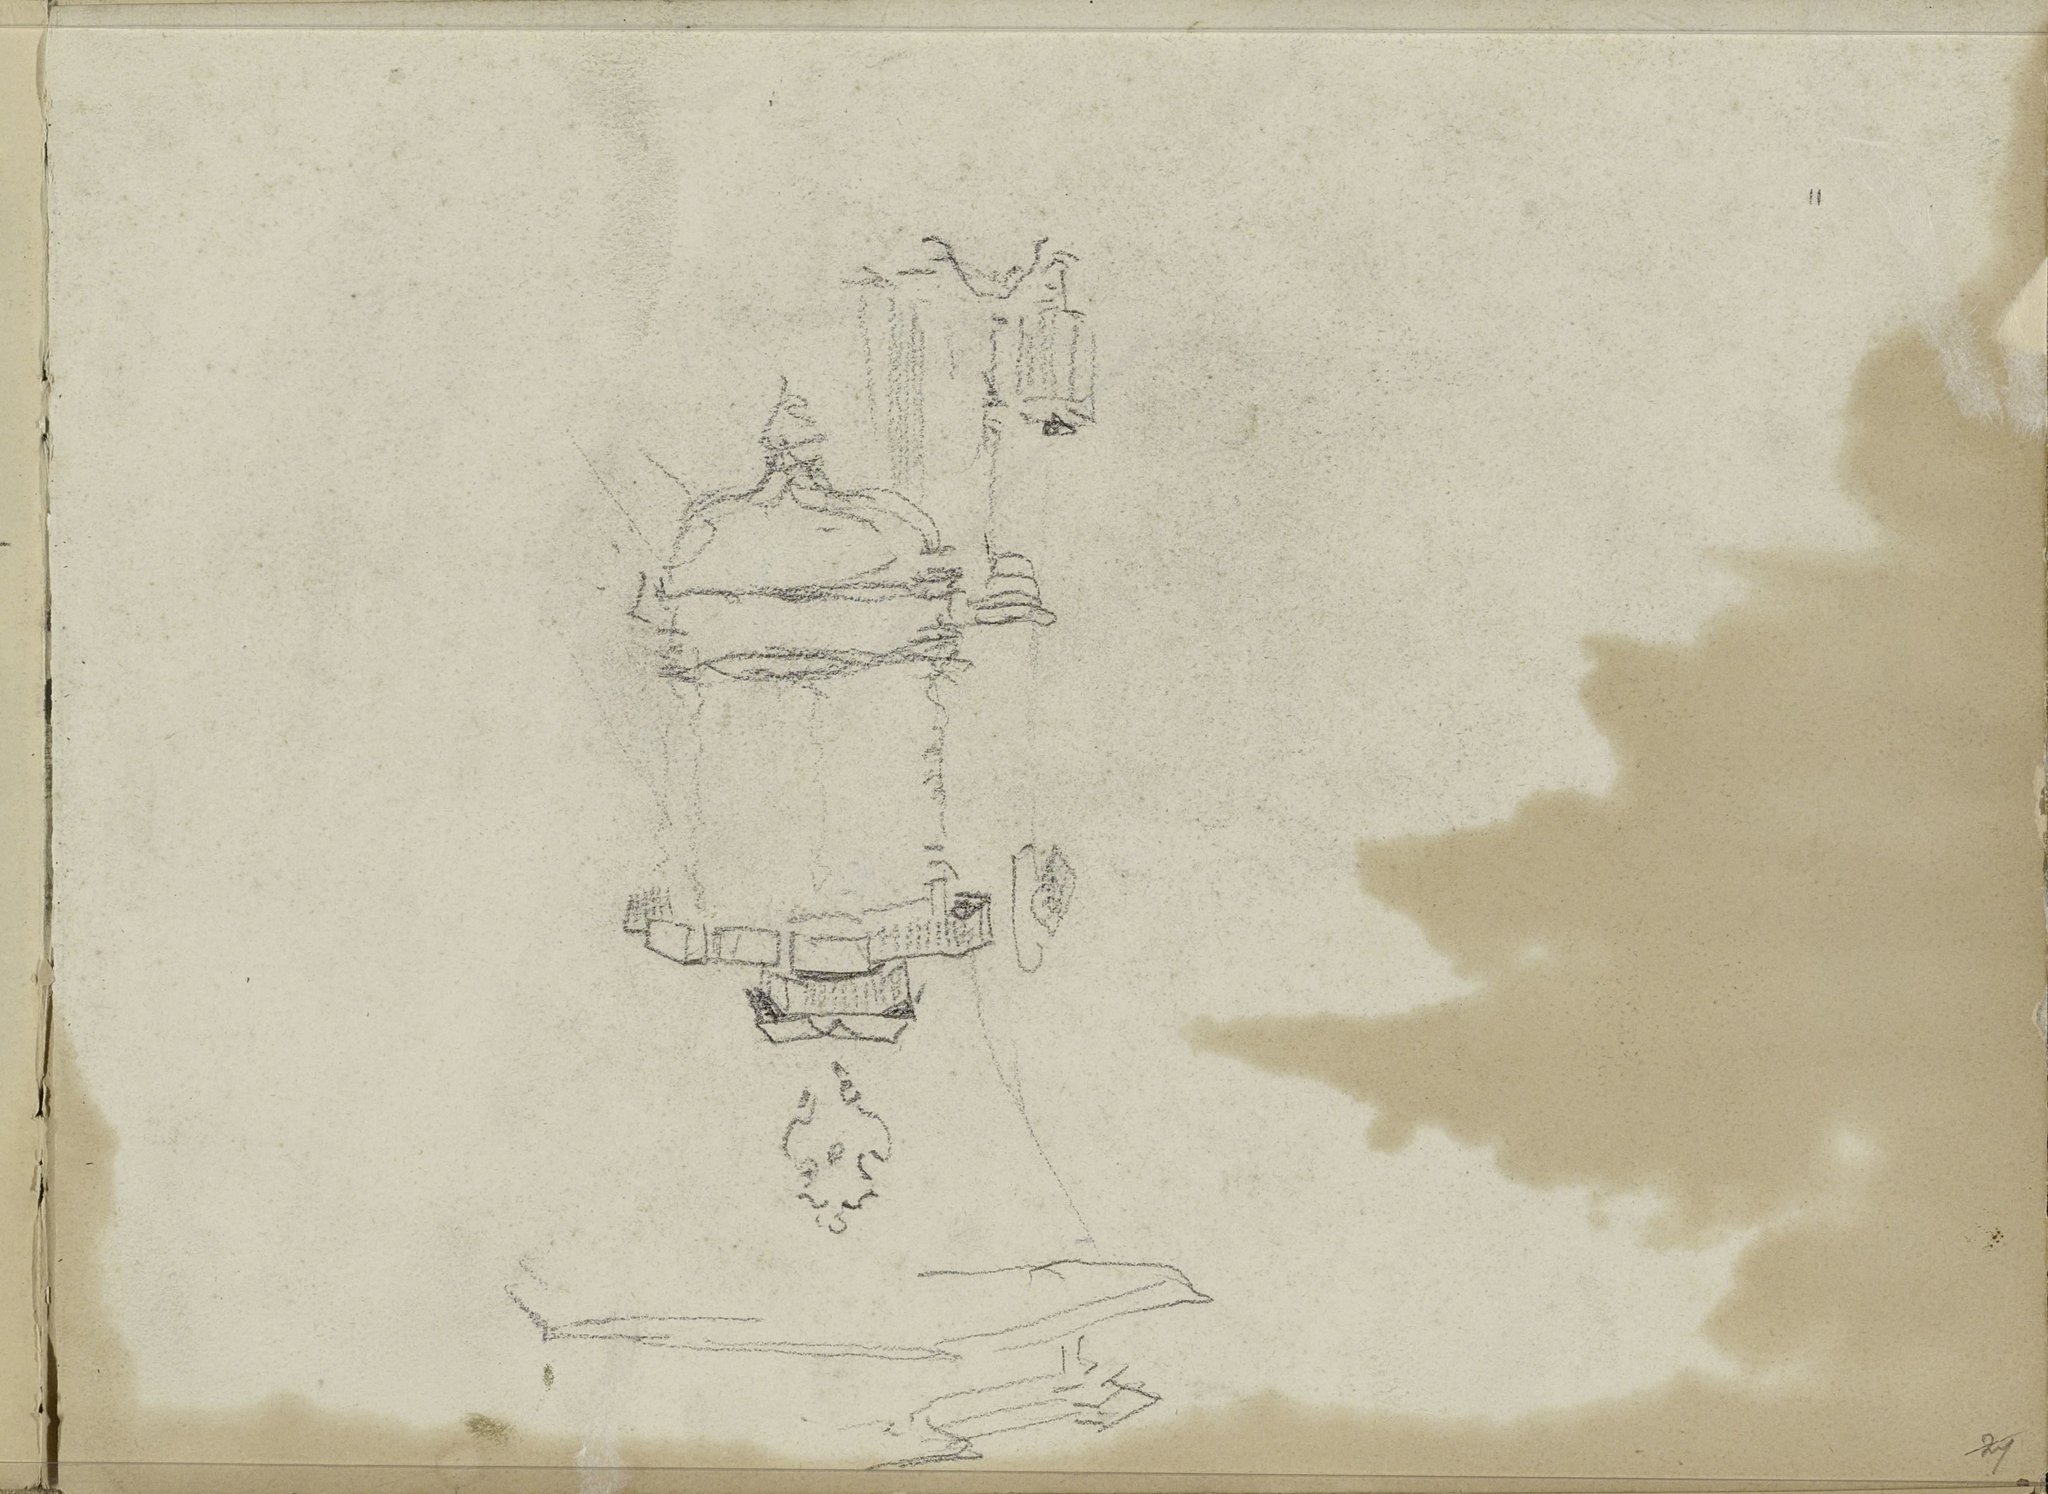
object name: sketchbook leaf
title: Architectuurdetail, vermoedelijk uit een kerk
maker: johannes bosboom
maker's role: draughtsman, painter, print maker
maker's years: 1817-1891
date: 1827-1891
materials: chalk, paper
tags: architectural detail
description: Blad 11 recto uit een schetsboek met 13 bladen.